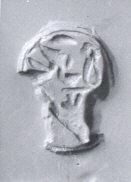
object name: stamp seal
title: Scarab seal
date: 2000-1 BCE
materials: stone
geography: egypt or levant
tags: scarabs